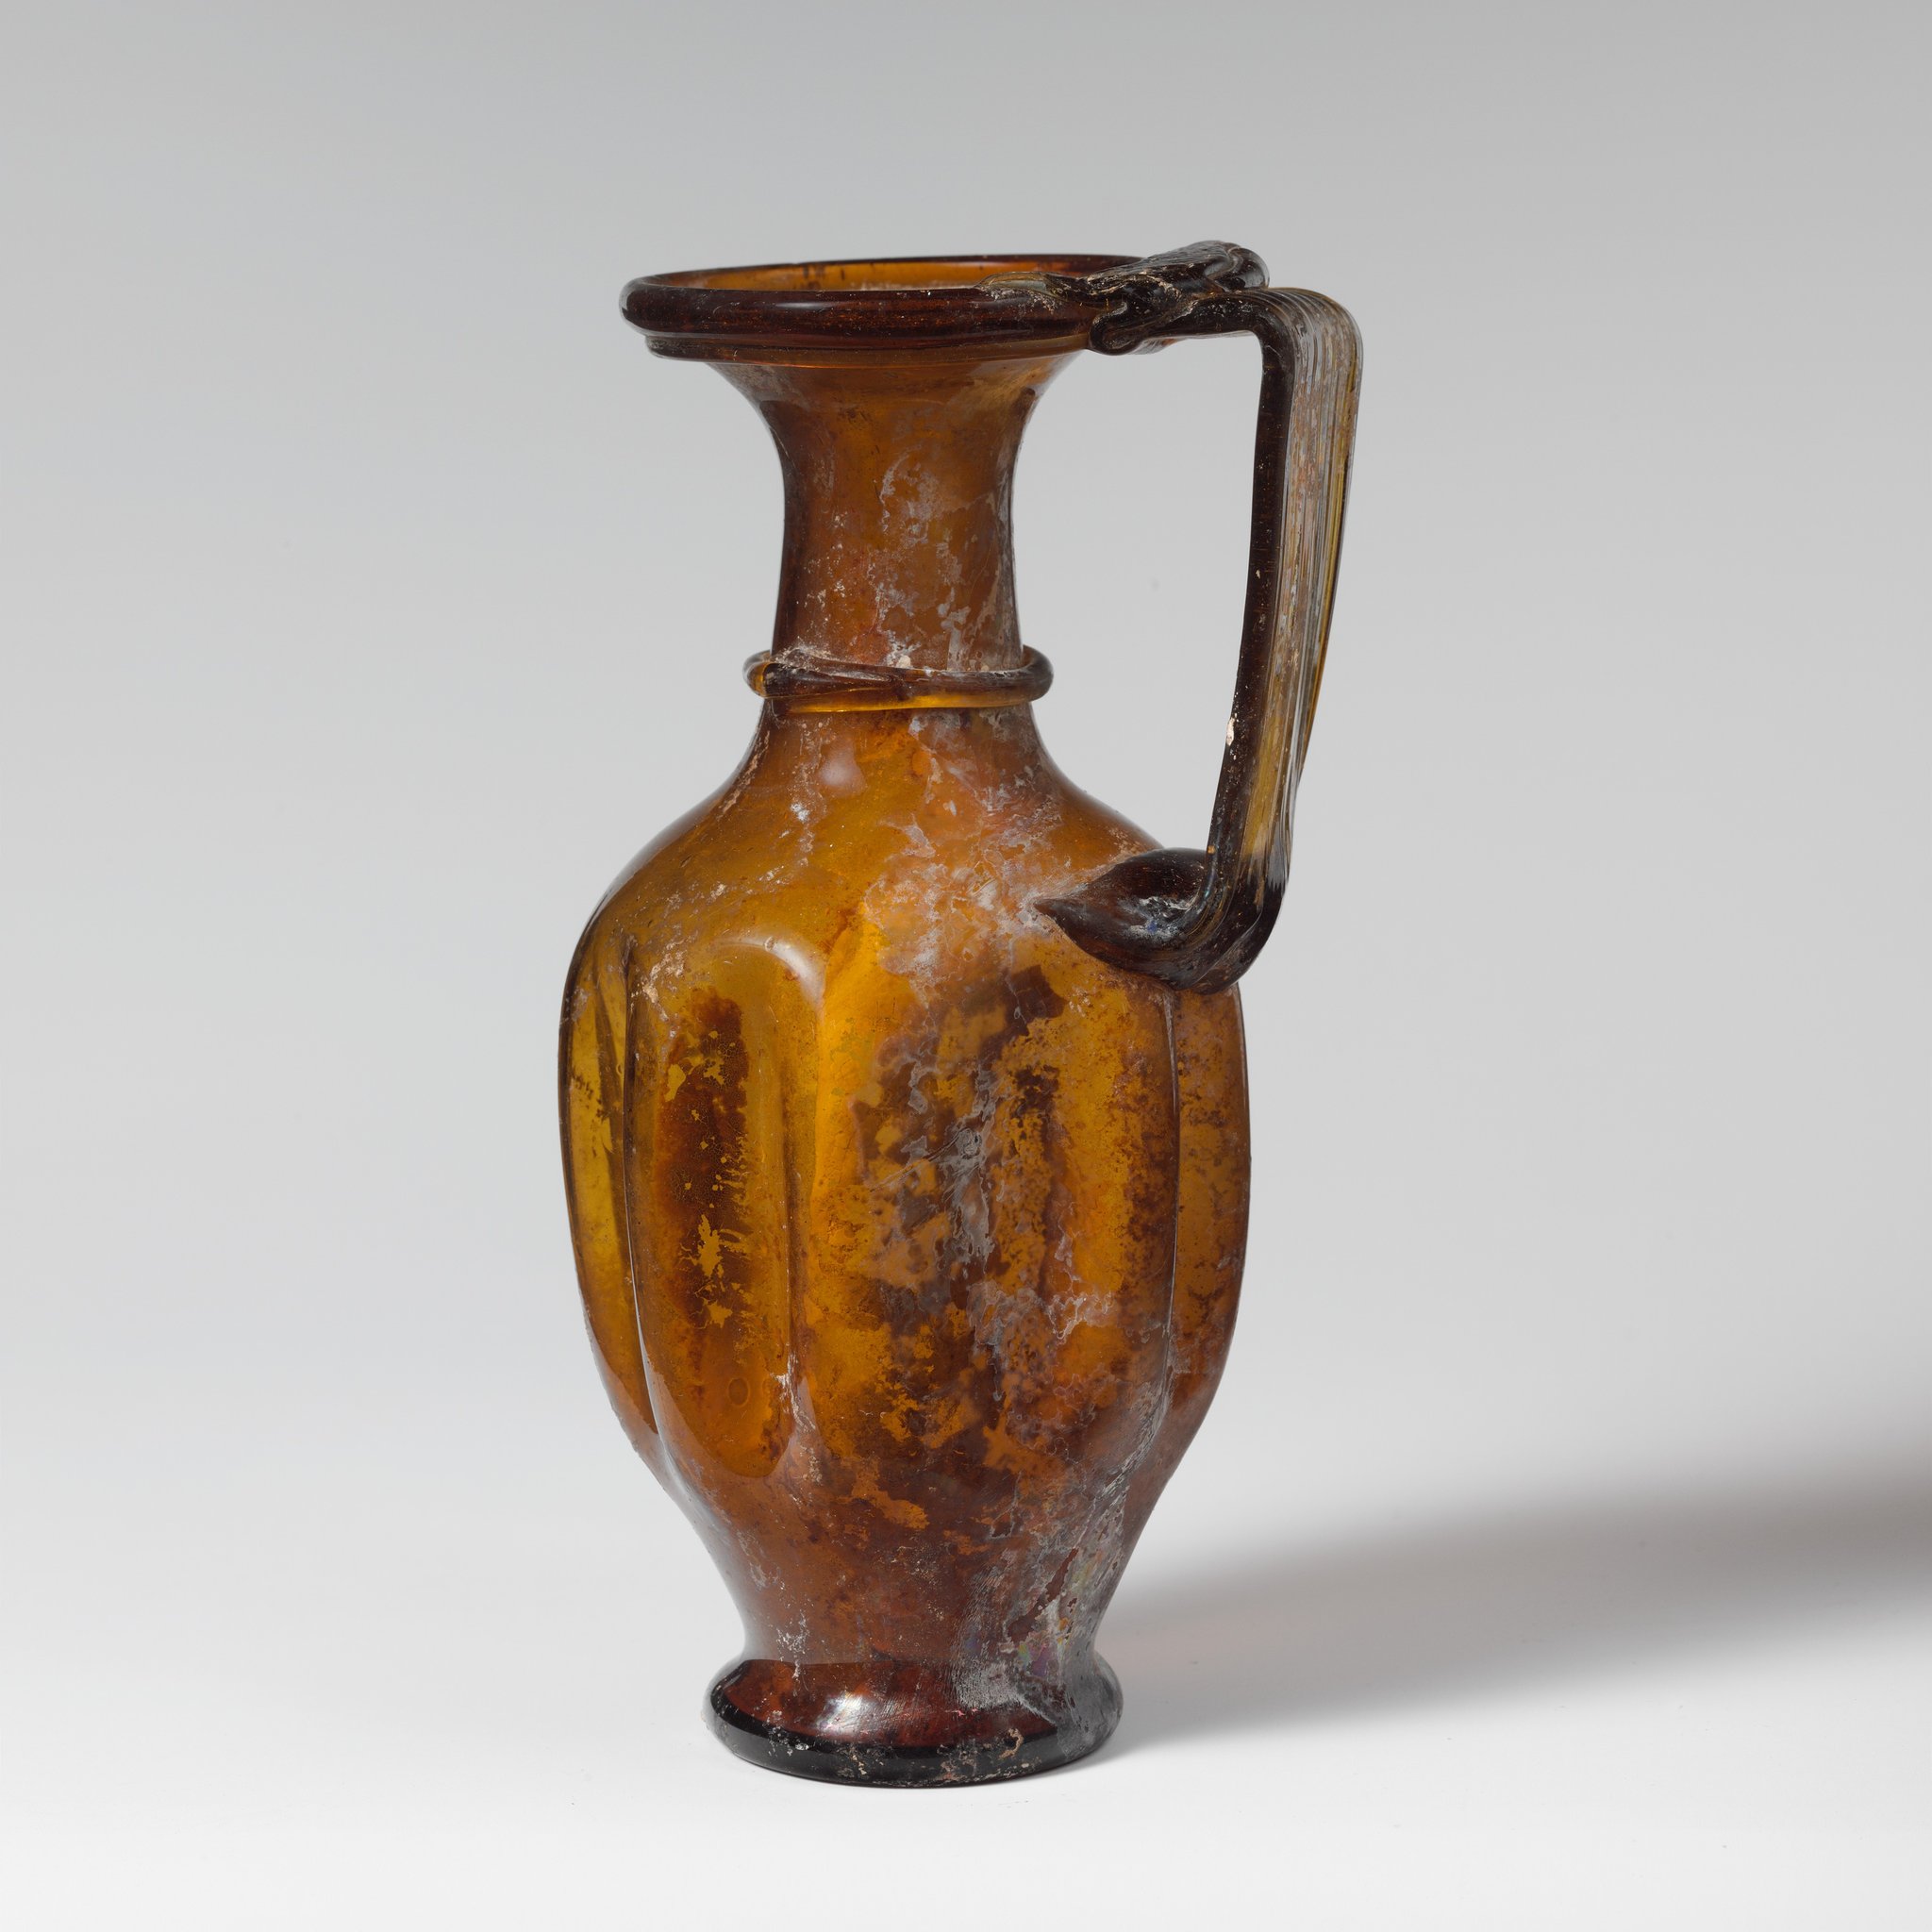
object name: jug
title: Glass jug with indented body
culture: roman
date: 301-500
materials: glass